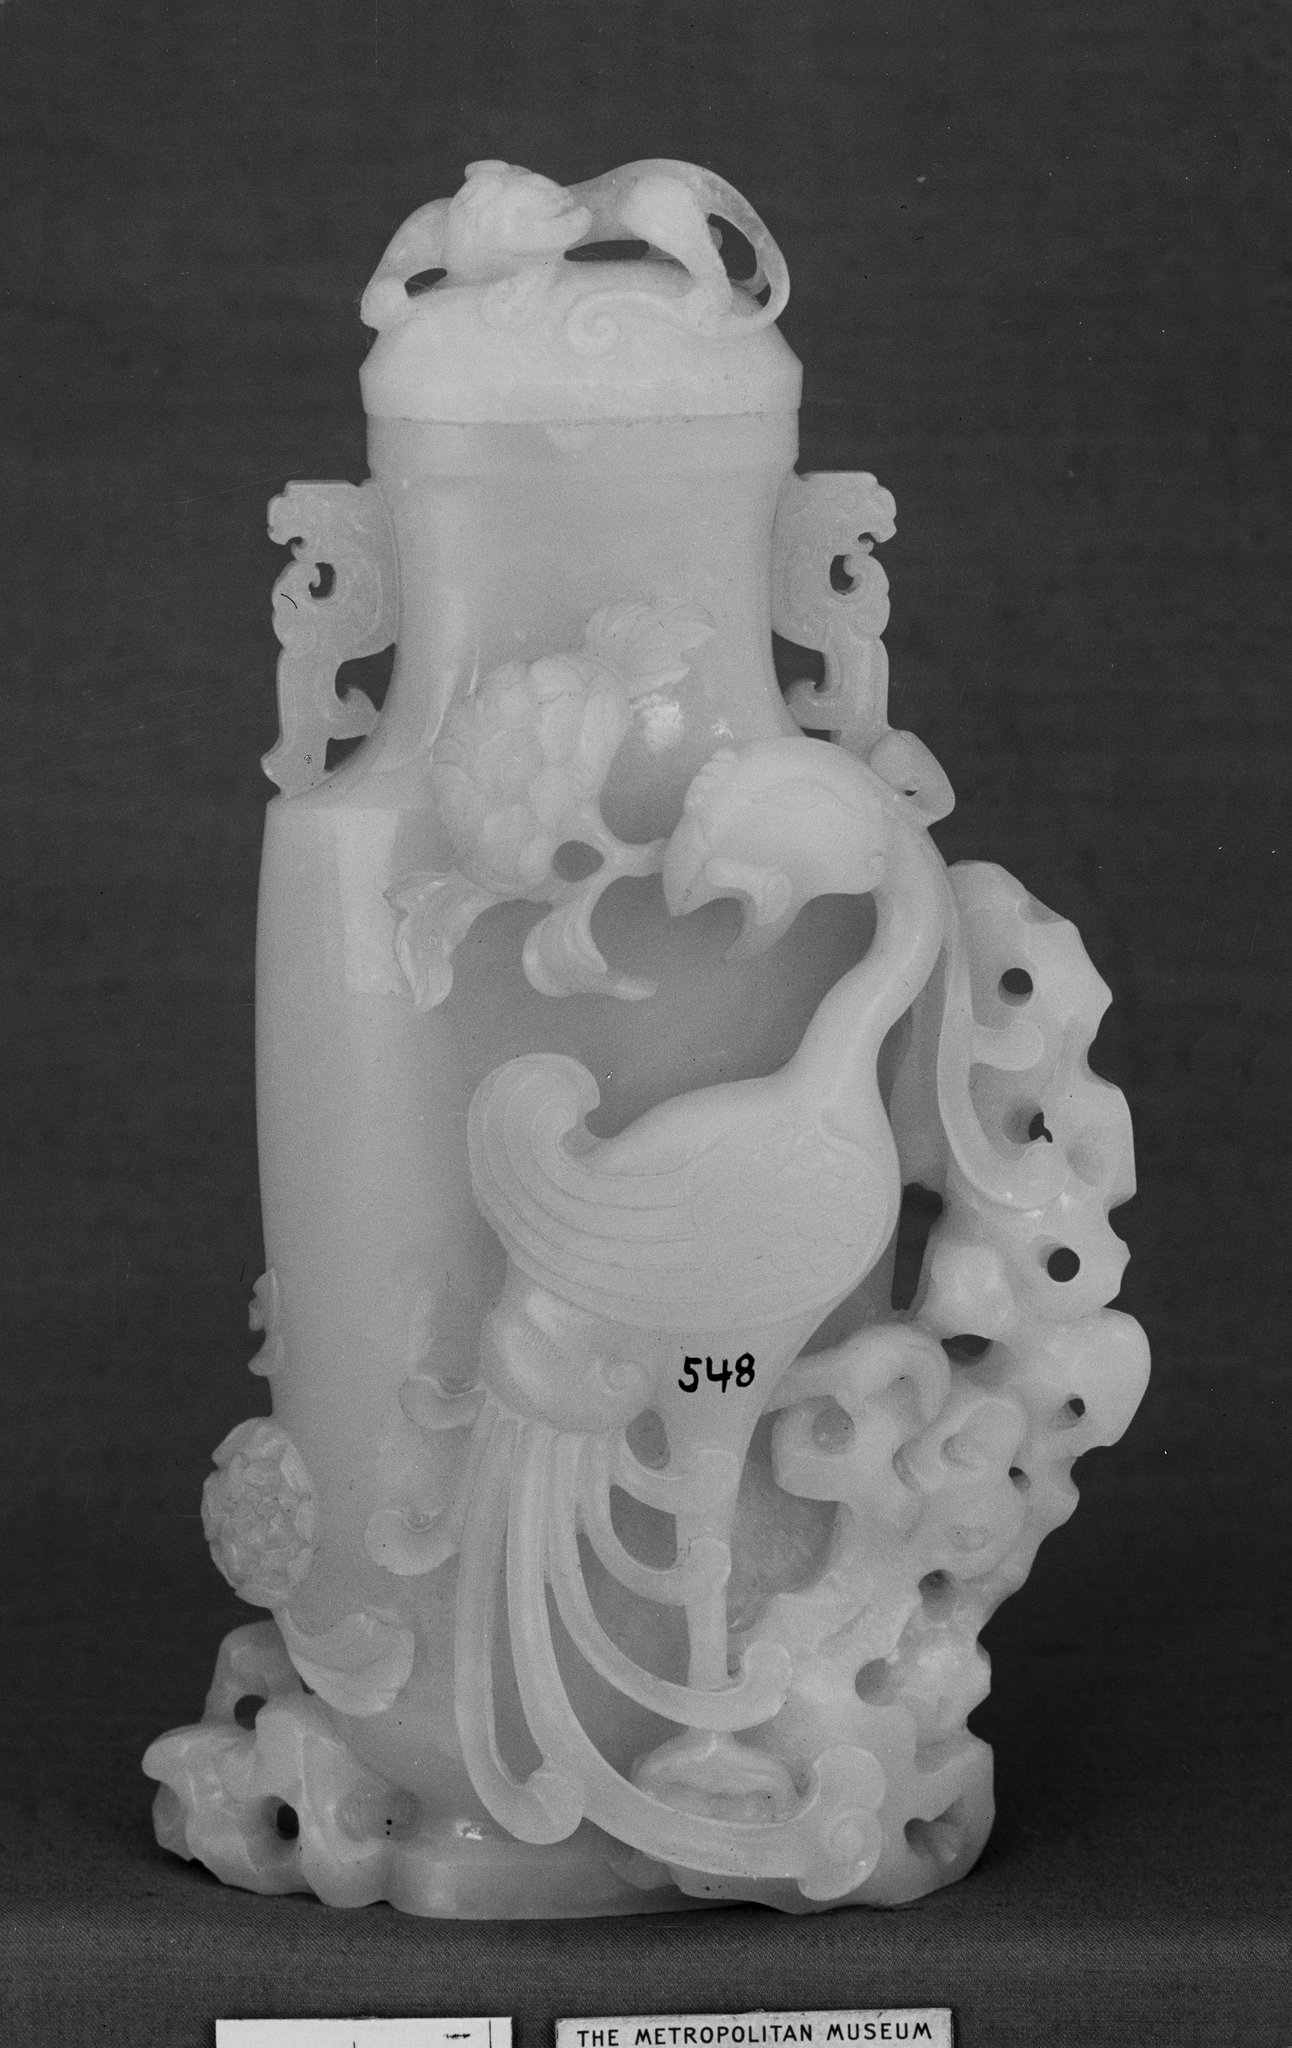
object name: vase with cover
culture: chinese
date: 1736-1795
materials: jade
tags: phoenix